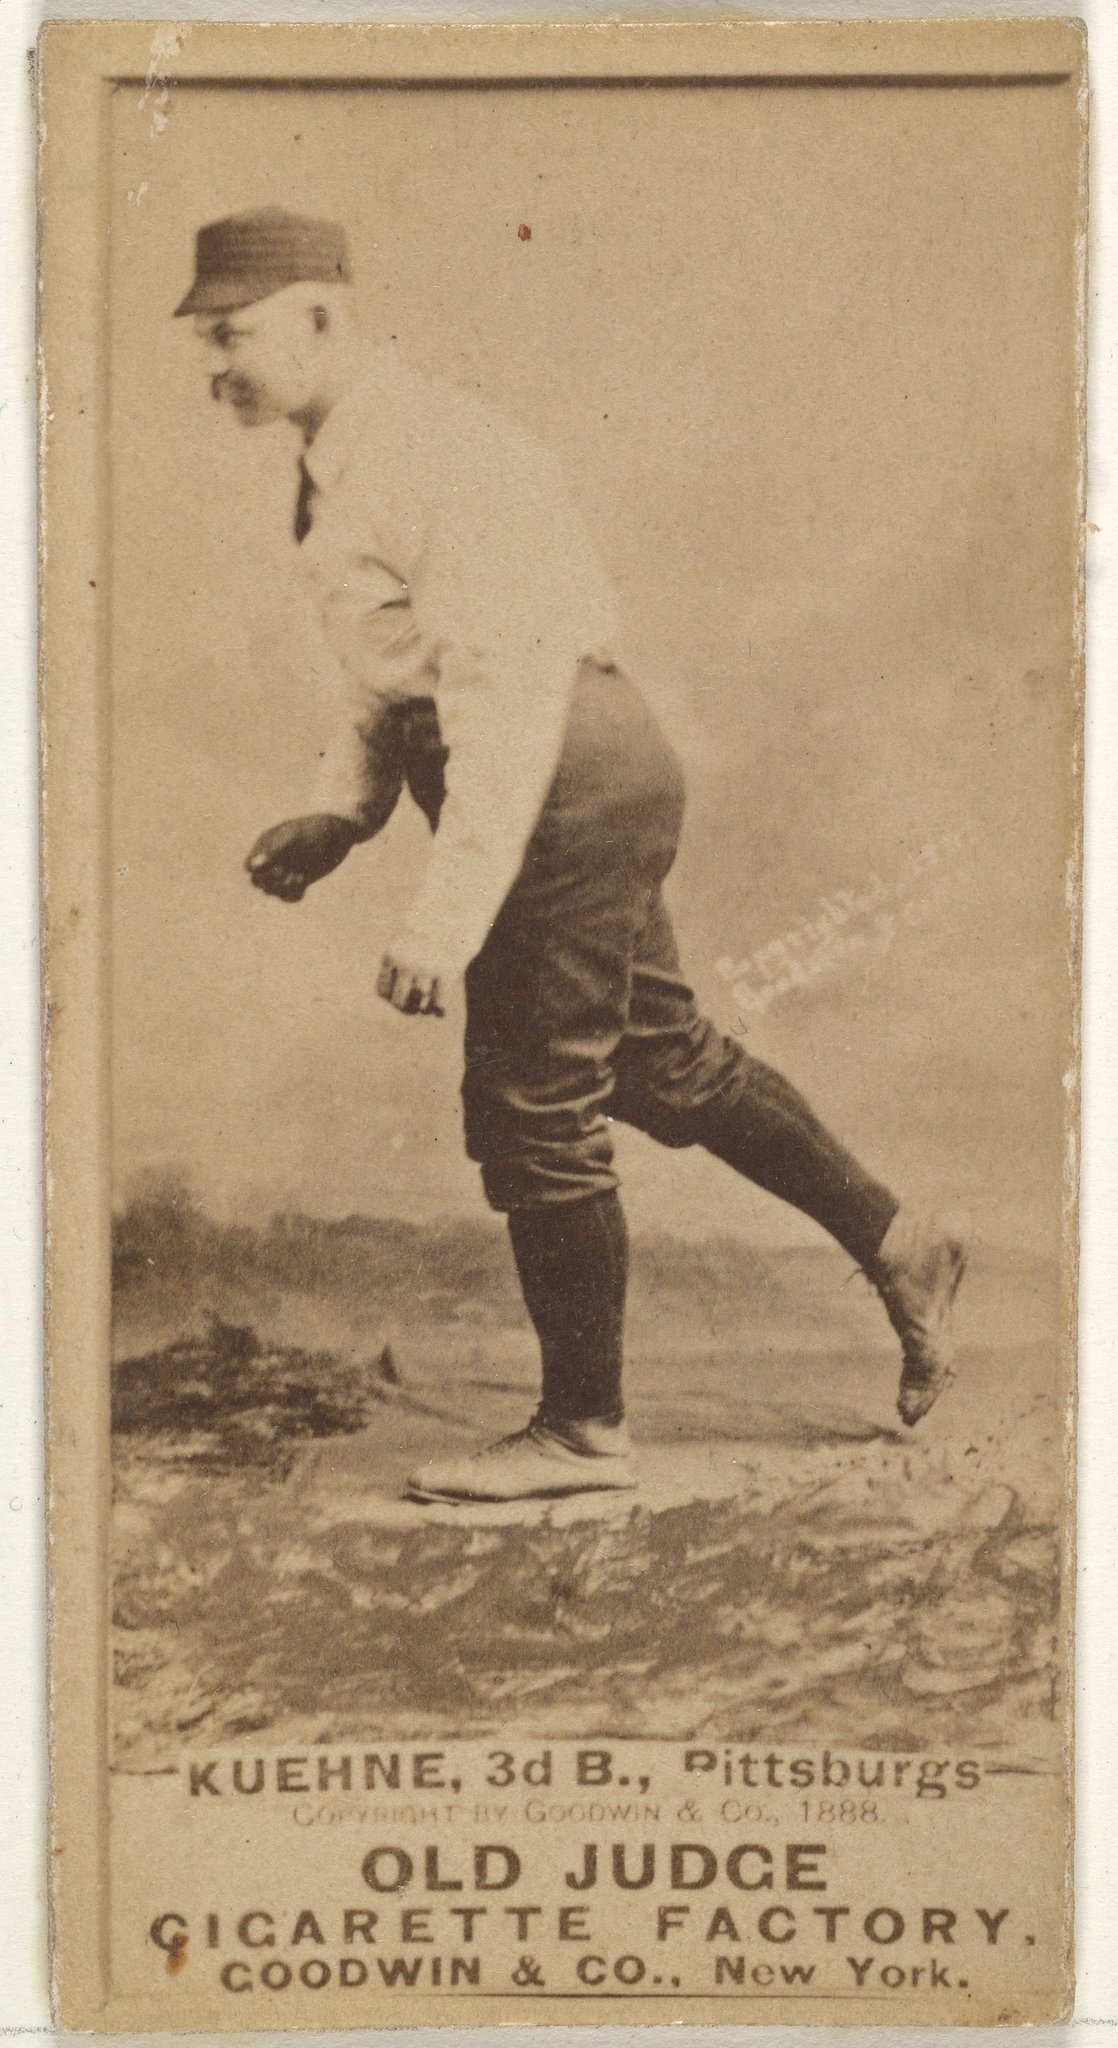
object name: baseball card, photograph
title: Bill Kuehne, 3rd Base, Pittsburgh, from the Old Judge series (N172) for Old Judge Cigarettes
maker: goodwin & company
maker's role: publisher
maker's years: 1850-1950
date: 1888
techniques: albumen silver print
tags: men,portraits,baseball,athletes